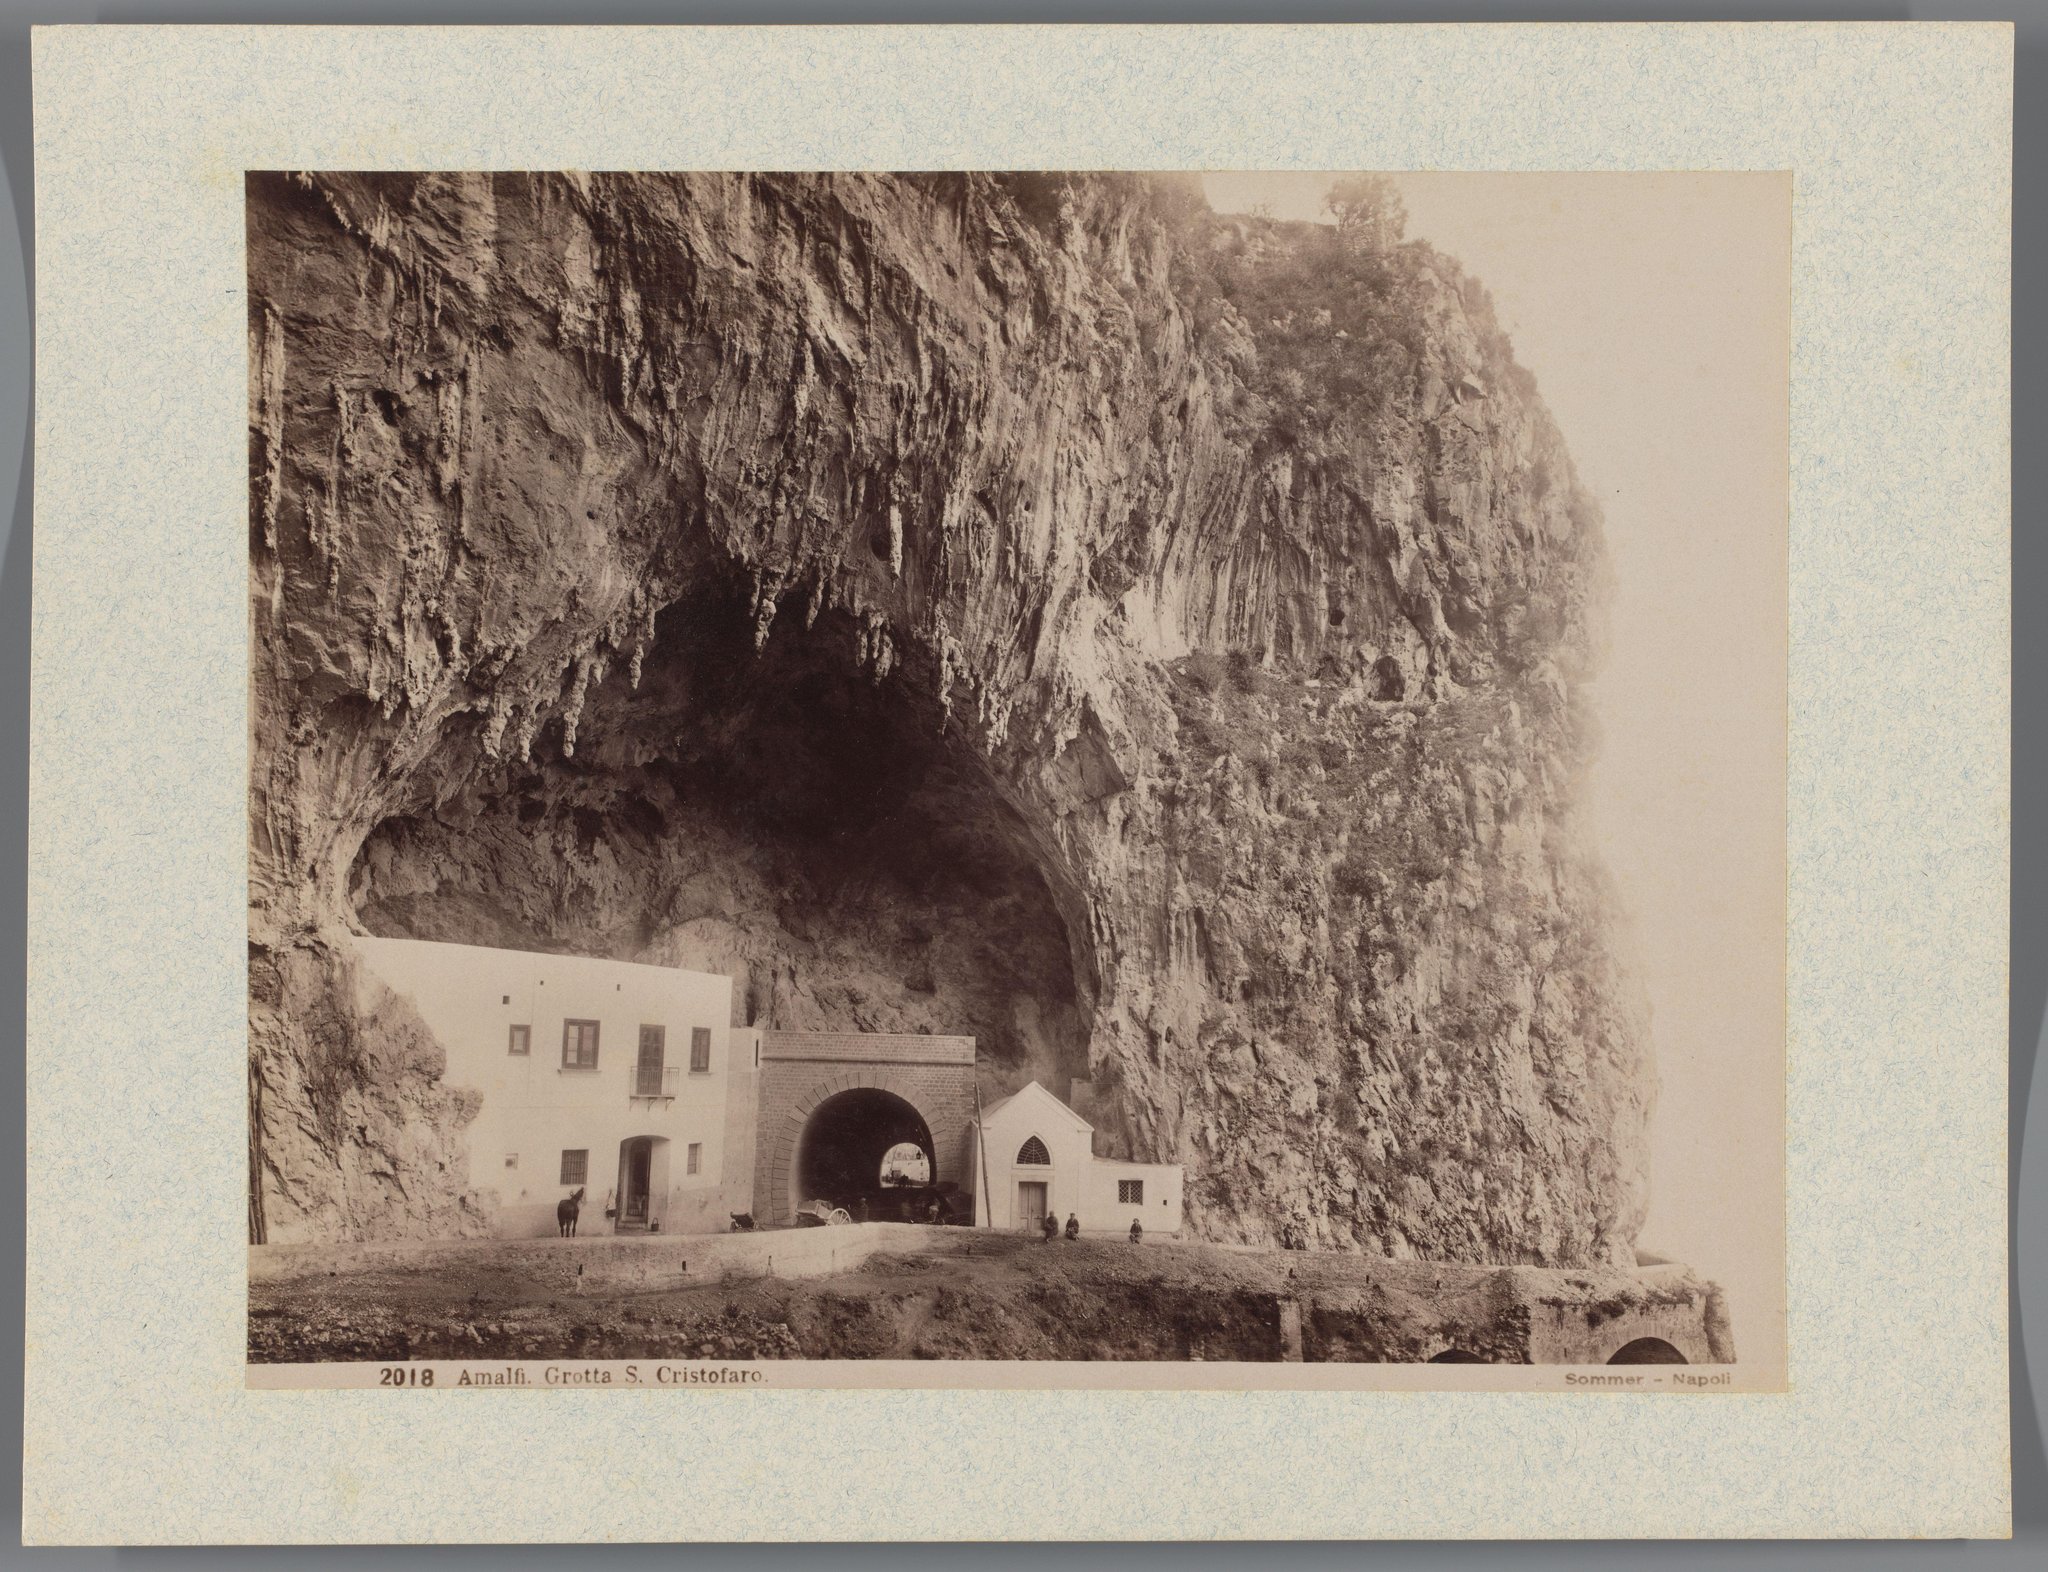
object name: photograph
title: Italië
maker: Anonymous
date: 1880-1910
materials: photographic support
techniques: albumen print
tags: italy